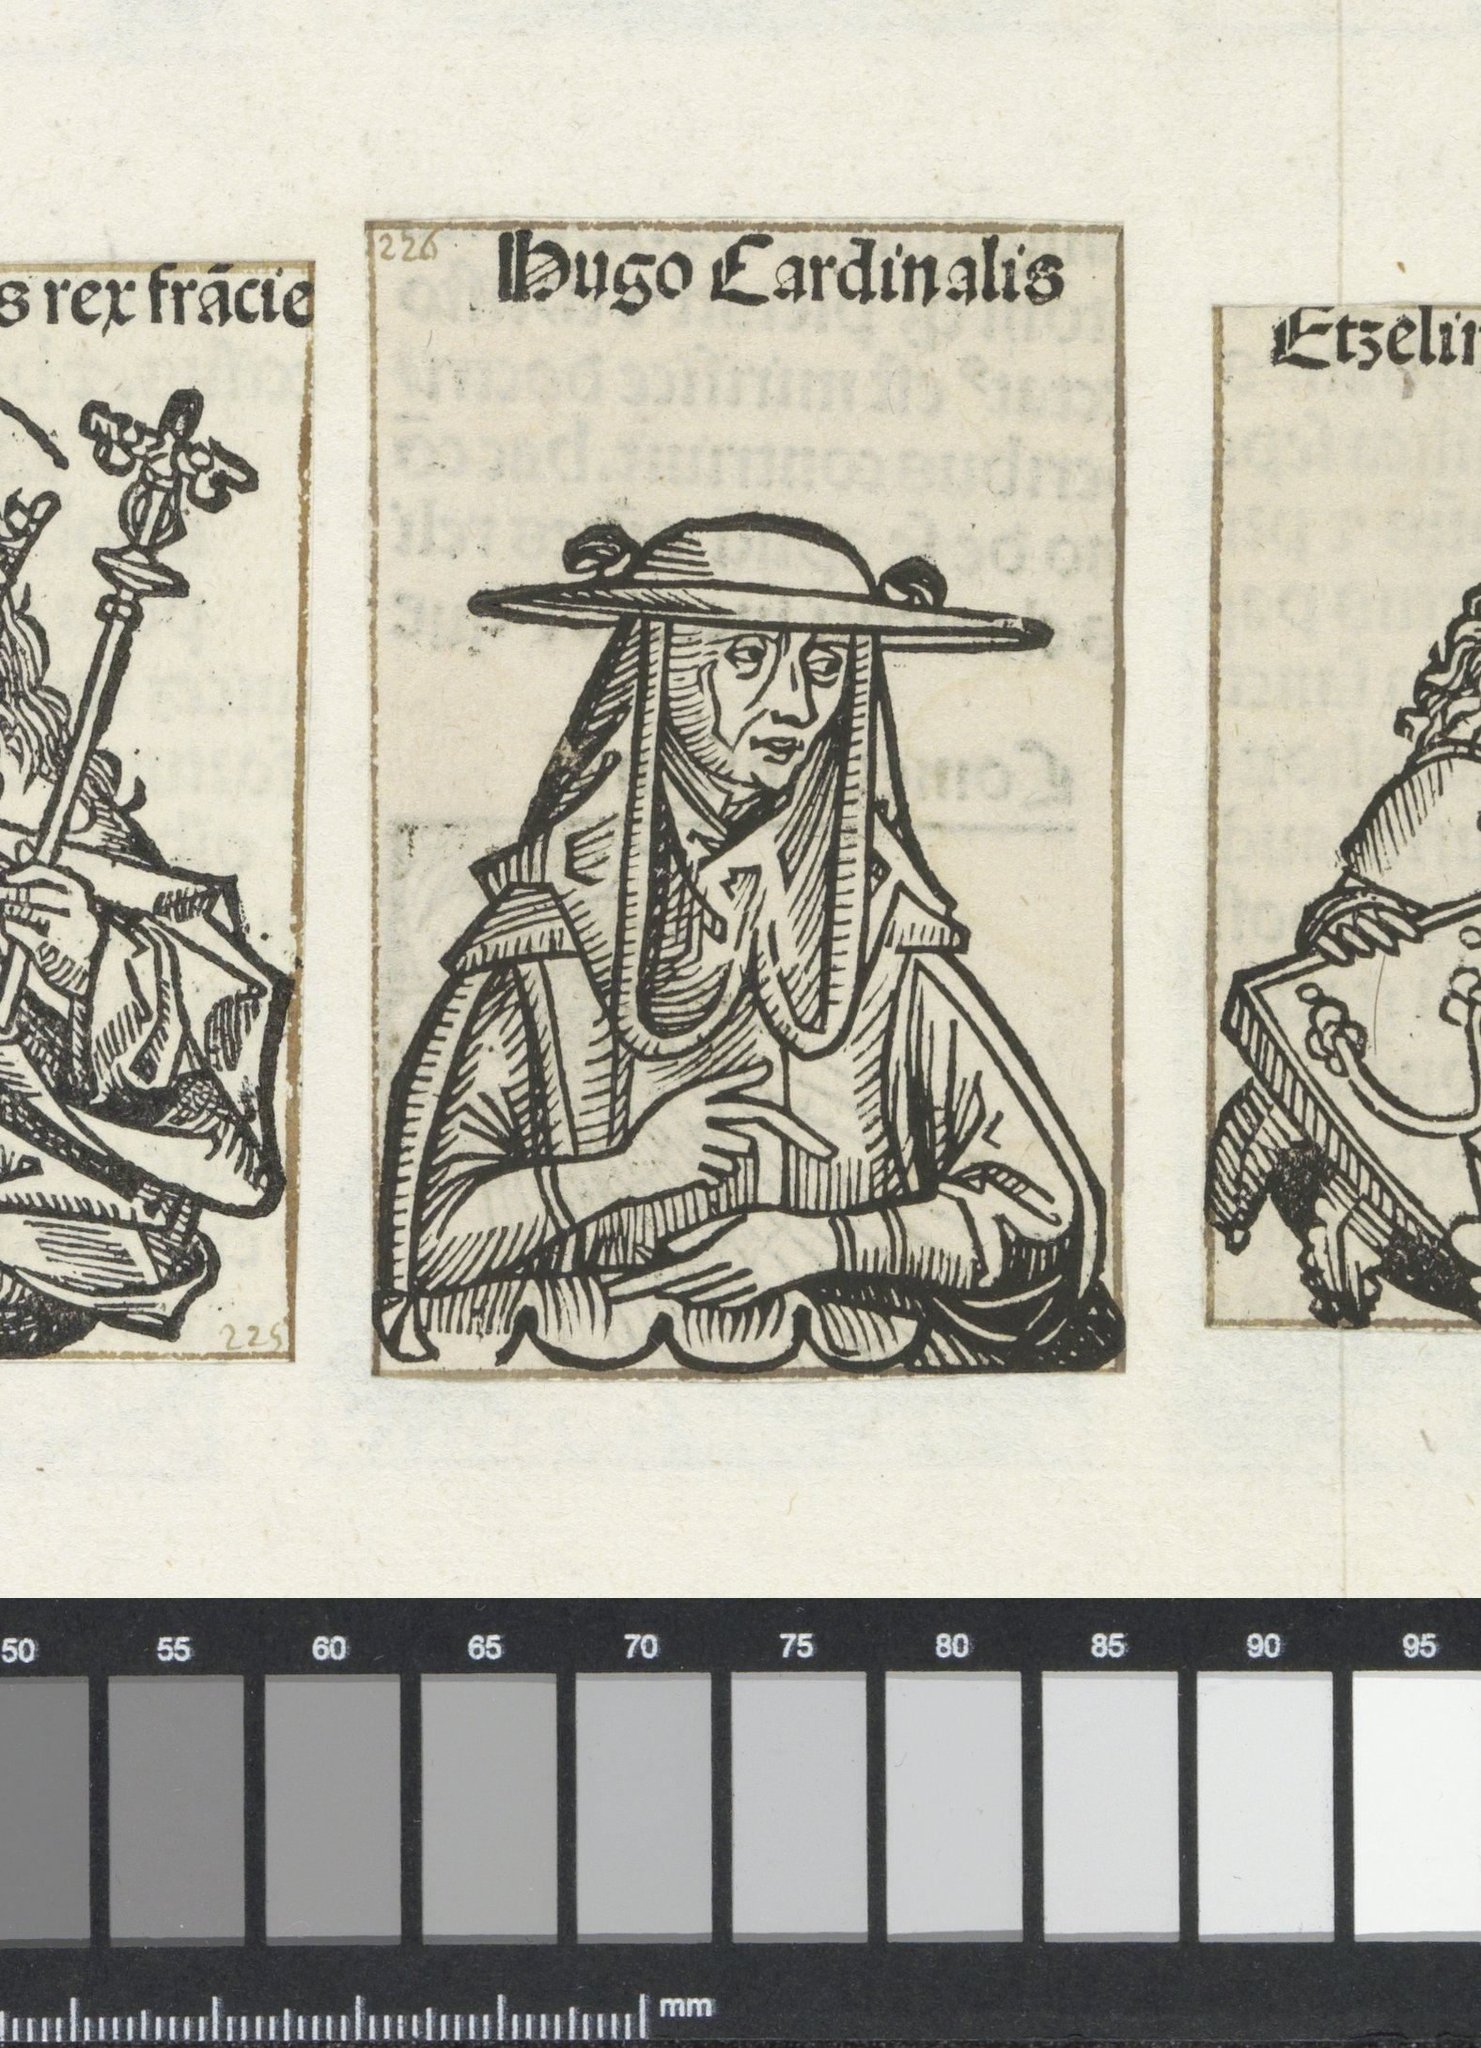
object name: album leaf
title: Hugo Cardinalis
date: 1493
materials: paper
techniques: letterpress printing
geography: nuremberg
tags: cardinal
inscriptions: inscription: ‘226’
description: De houtsnede wordt herhaaldelijk gebruikt als boekillustratie in de Liber Chronicarum (of Neurenbergkroniek) van Hartmann Schedel, verschenen in het Latijn en Duits in 1493. Zie de Latijnse uitgave, folio 213r.